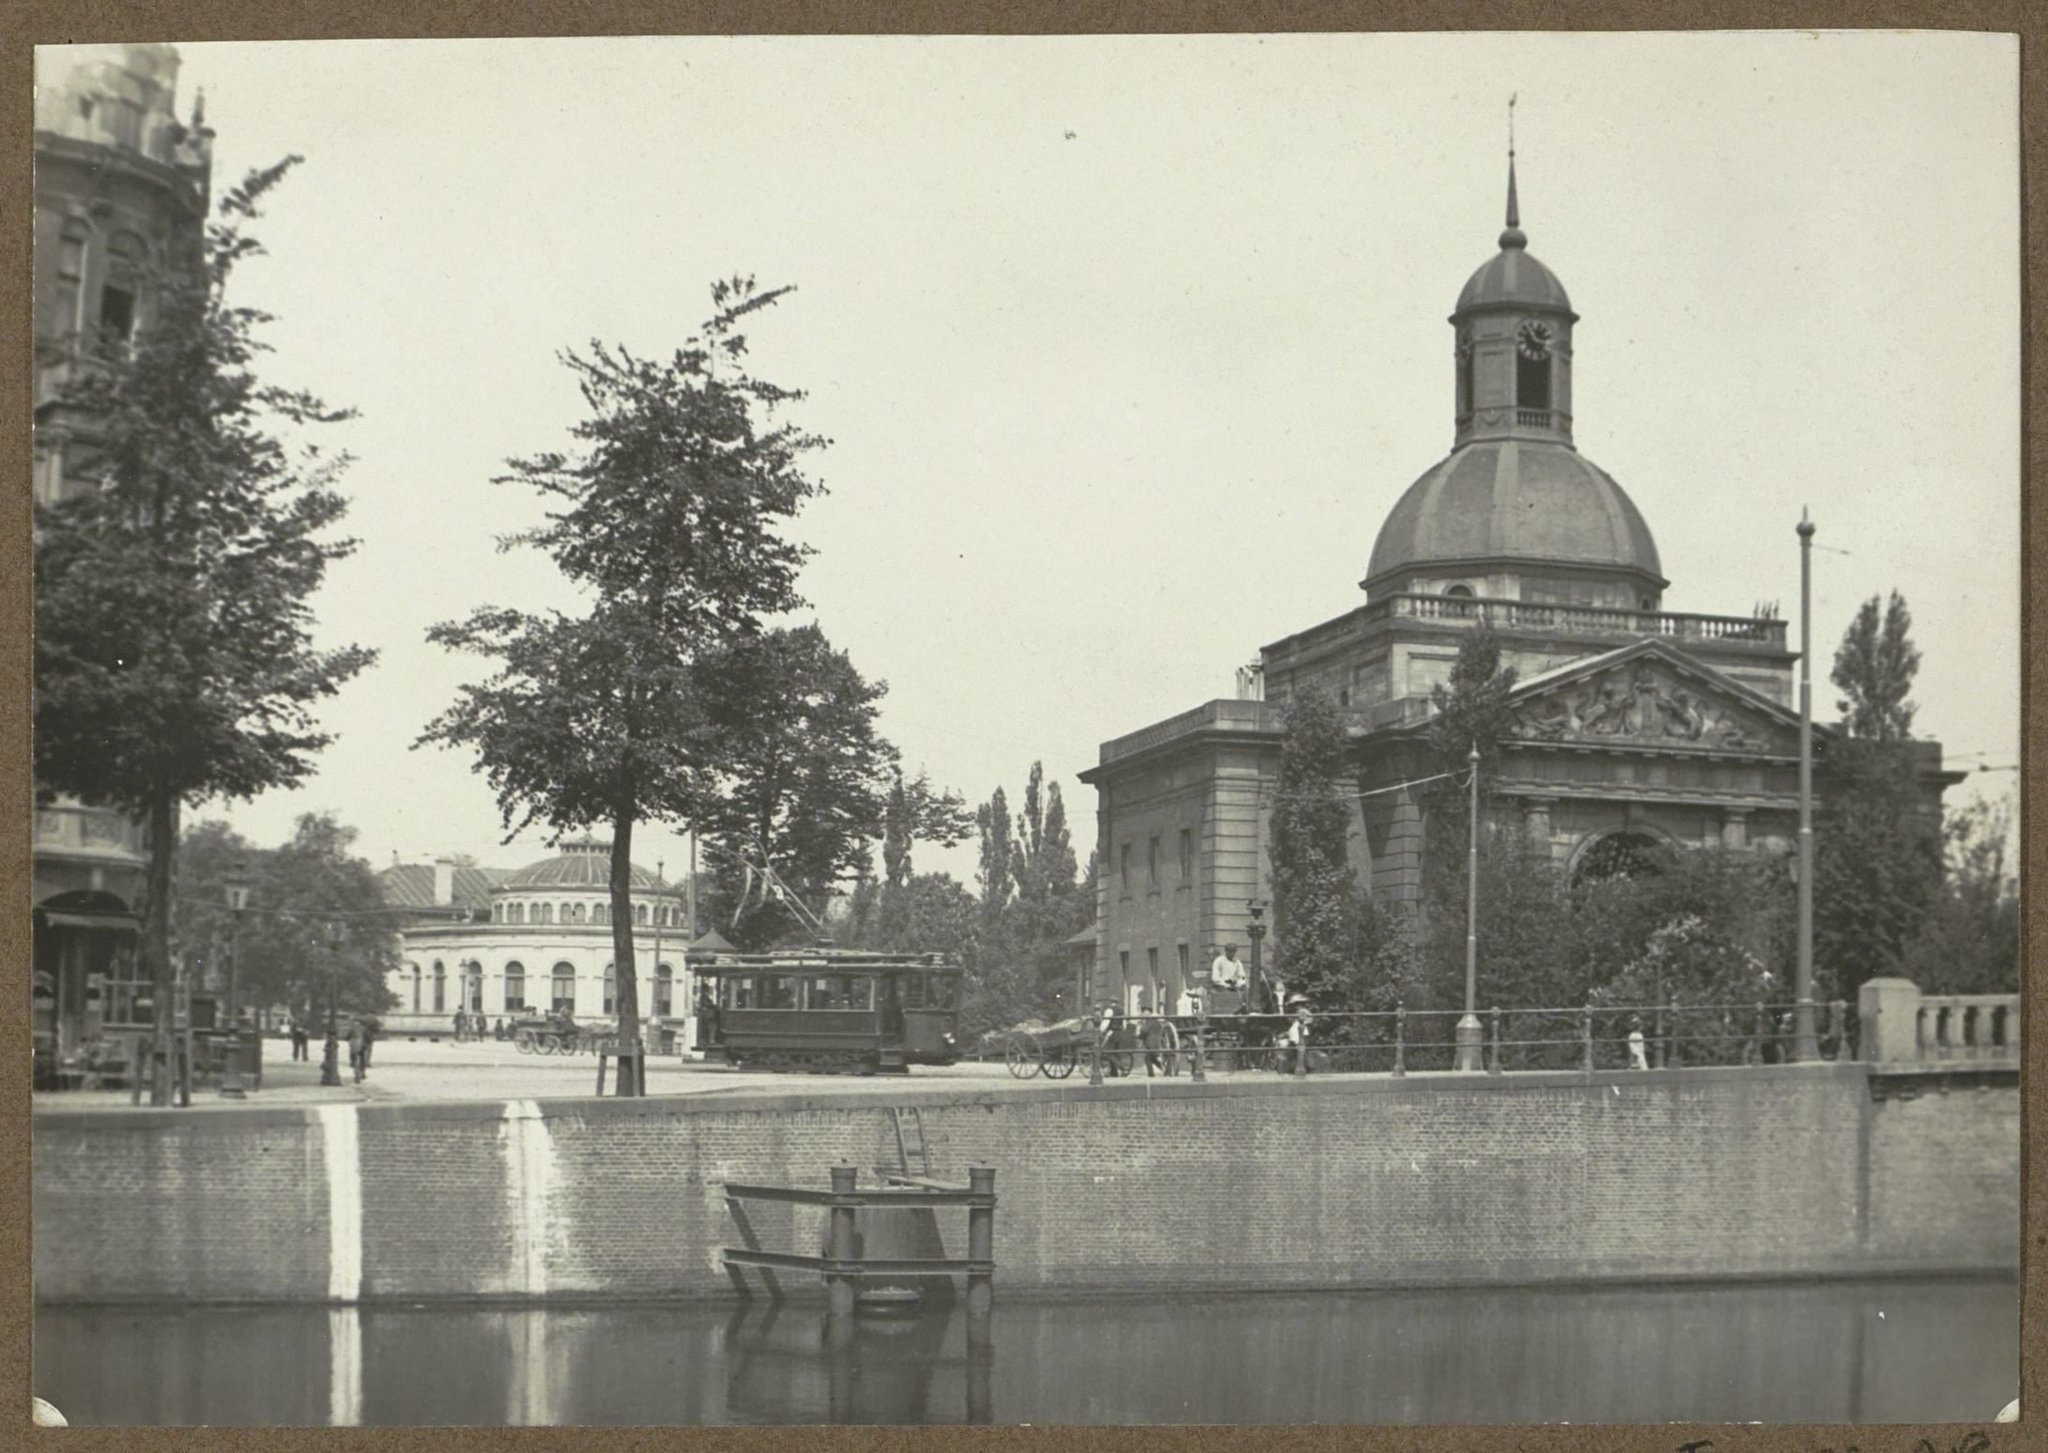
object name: photograph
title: Muiderpoort te Amsterdam gezien vanaf de Mauritskade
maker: Anonymous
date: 1910-1930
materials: paper, photographic support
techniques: gelatin silver print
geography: amsterdam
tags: gate ~ fortified city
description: Onderdeel van Album met foto's van Amsterdam en omgeving.